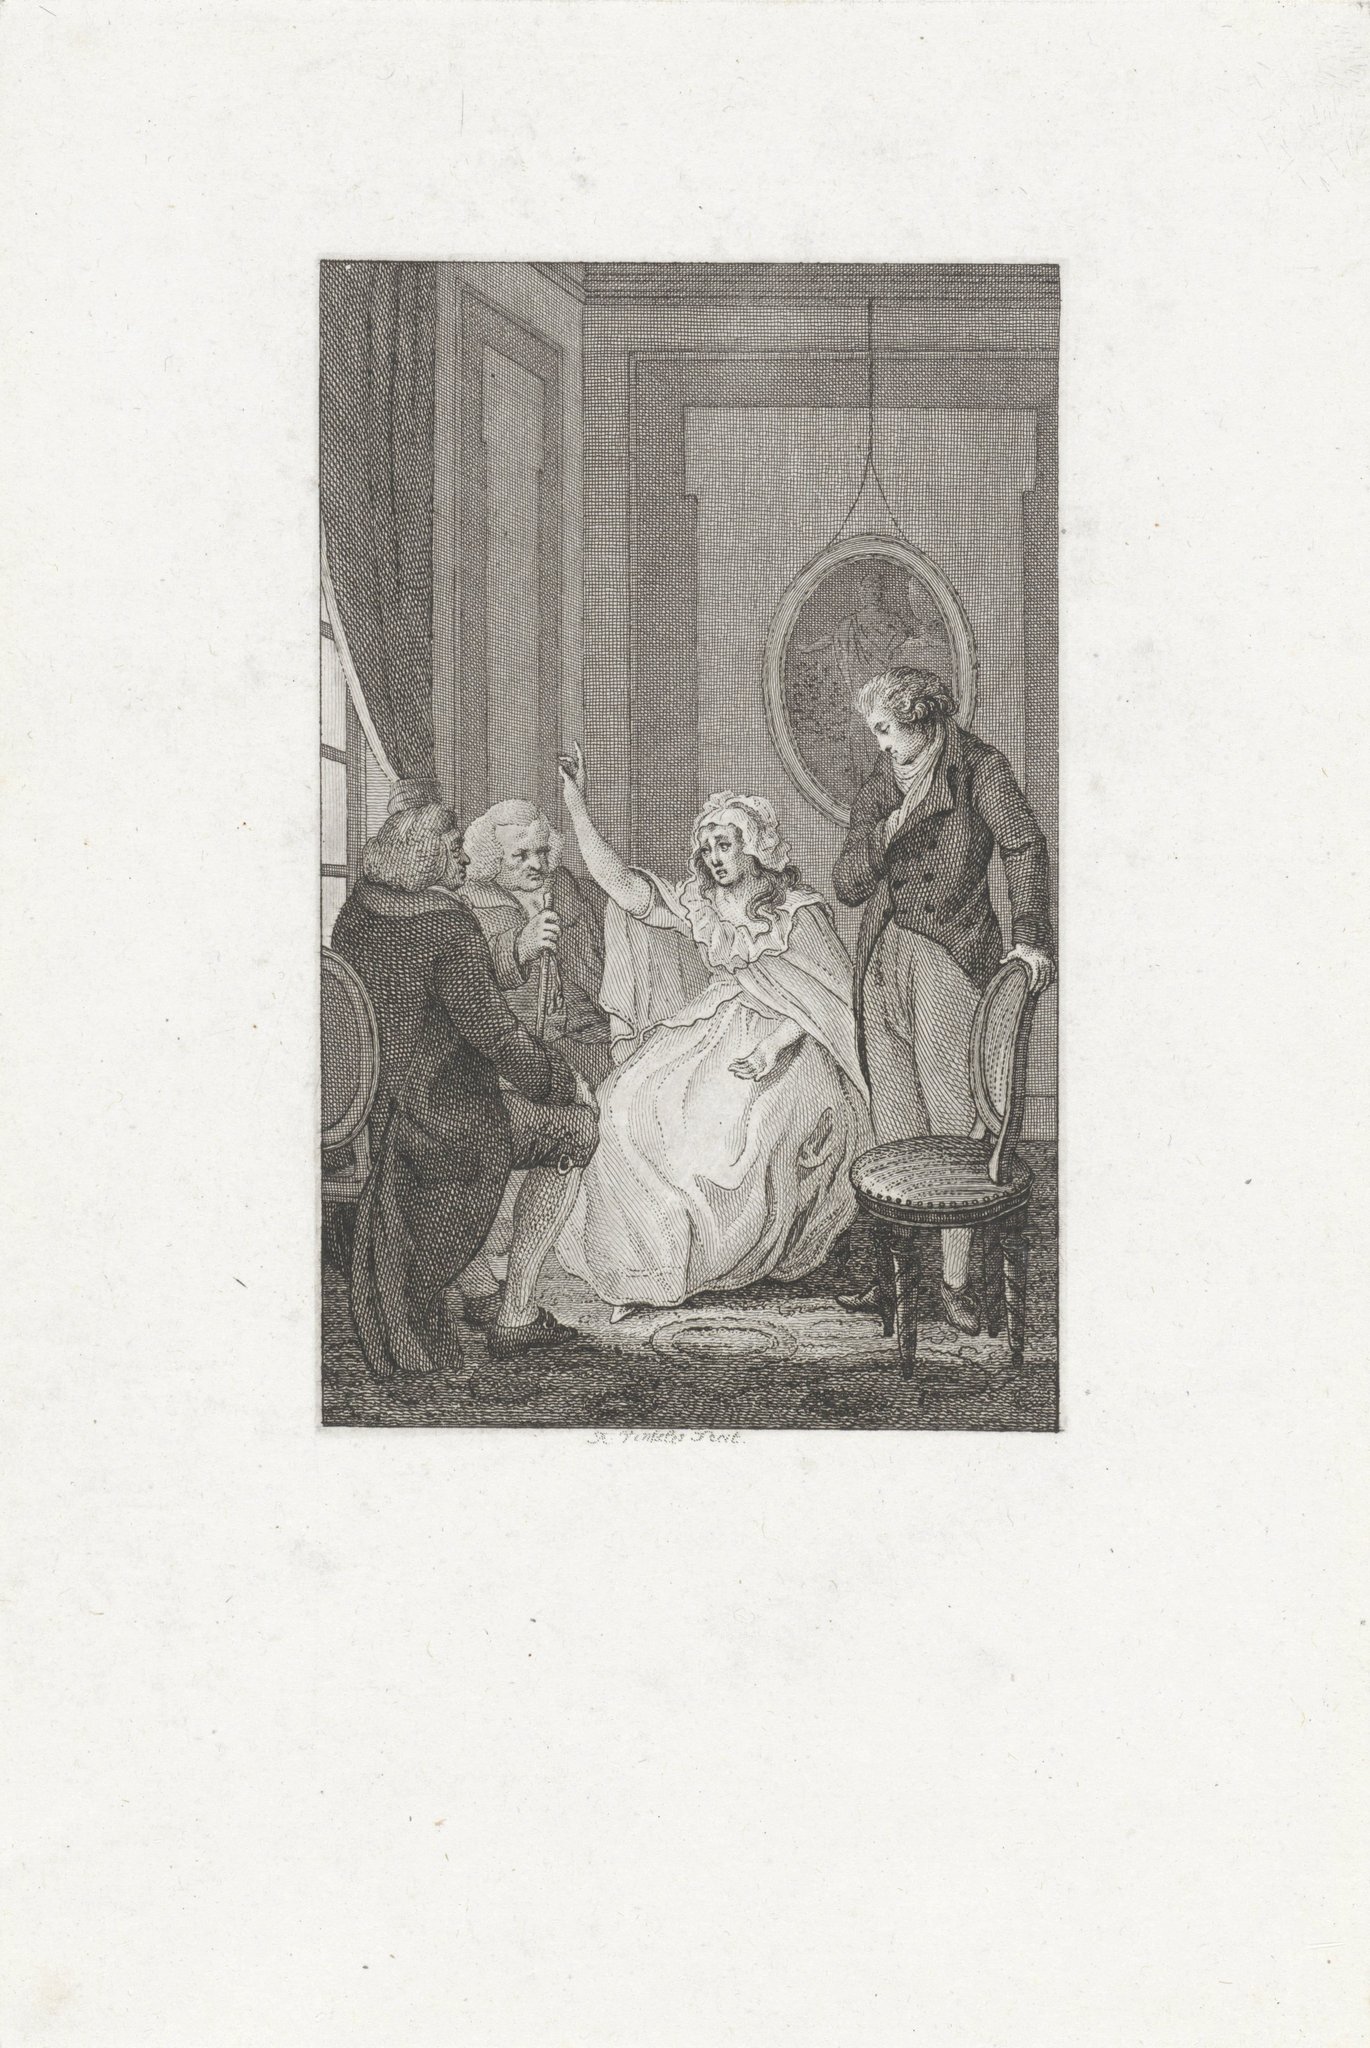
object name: print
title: Jonge vrouw in gesprek met drie heren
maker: reinier vinkeles (i)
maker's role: draughtsman, print maker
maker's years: 1741-1816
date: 1804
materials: paper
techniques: engraving, etching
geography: amsterdam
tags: picture, painting, index finger upwards, conversation, dialogue; conversation piece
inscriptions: collector's mark: Lugt 240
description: In een vertrek lijkt een vrouw iets duidelijk te willen maken aan drie mannen, waarvan er een naast haar staat. Ze wijst met haar wijsvinger in de lucht.